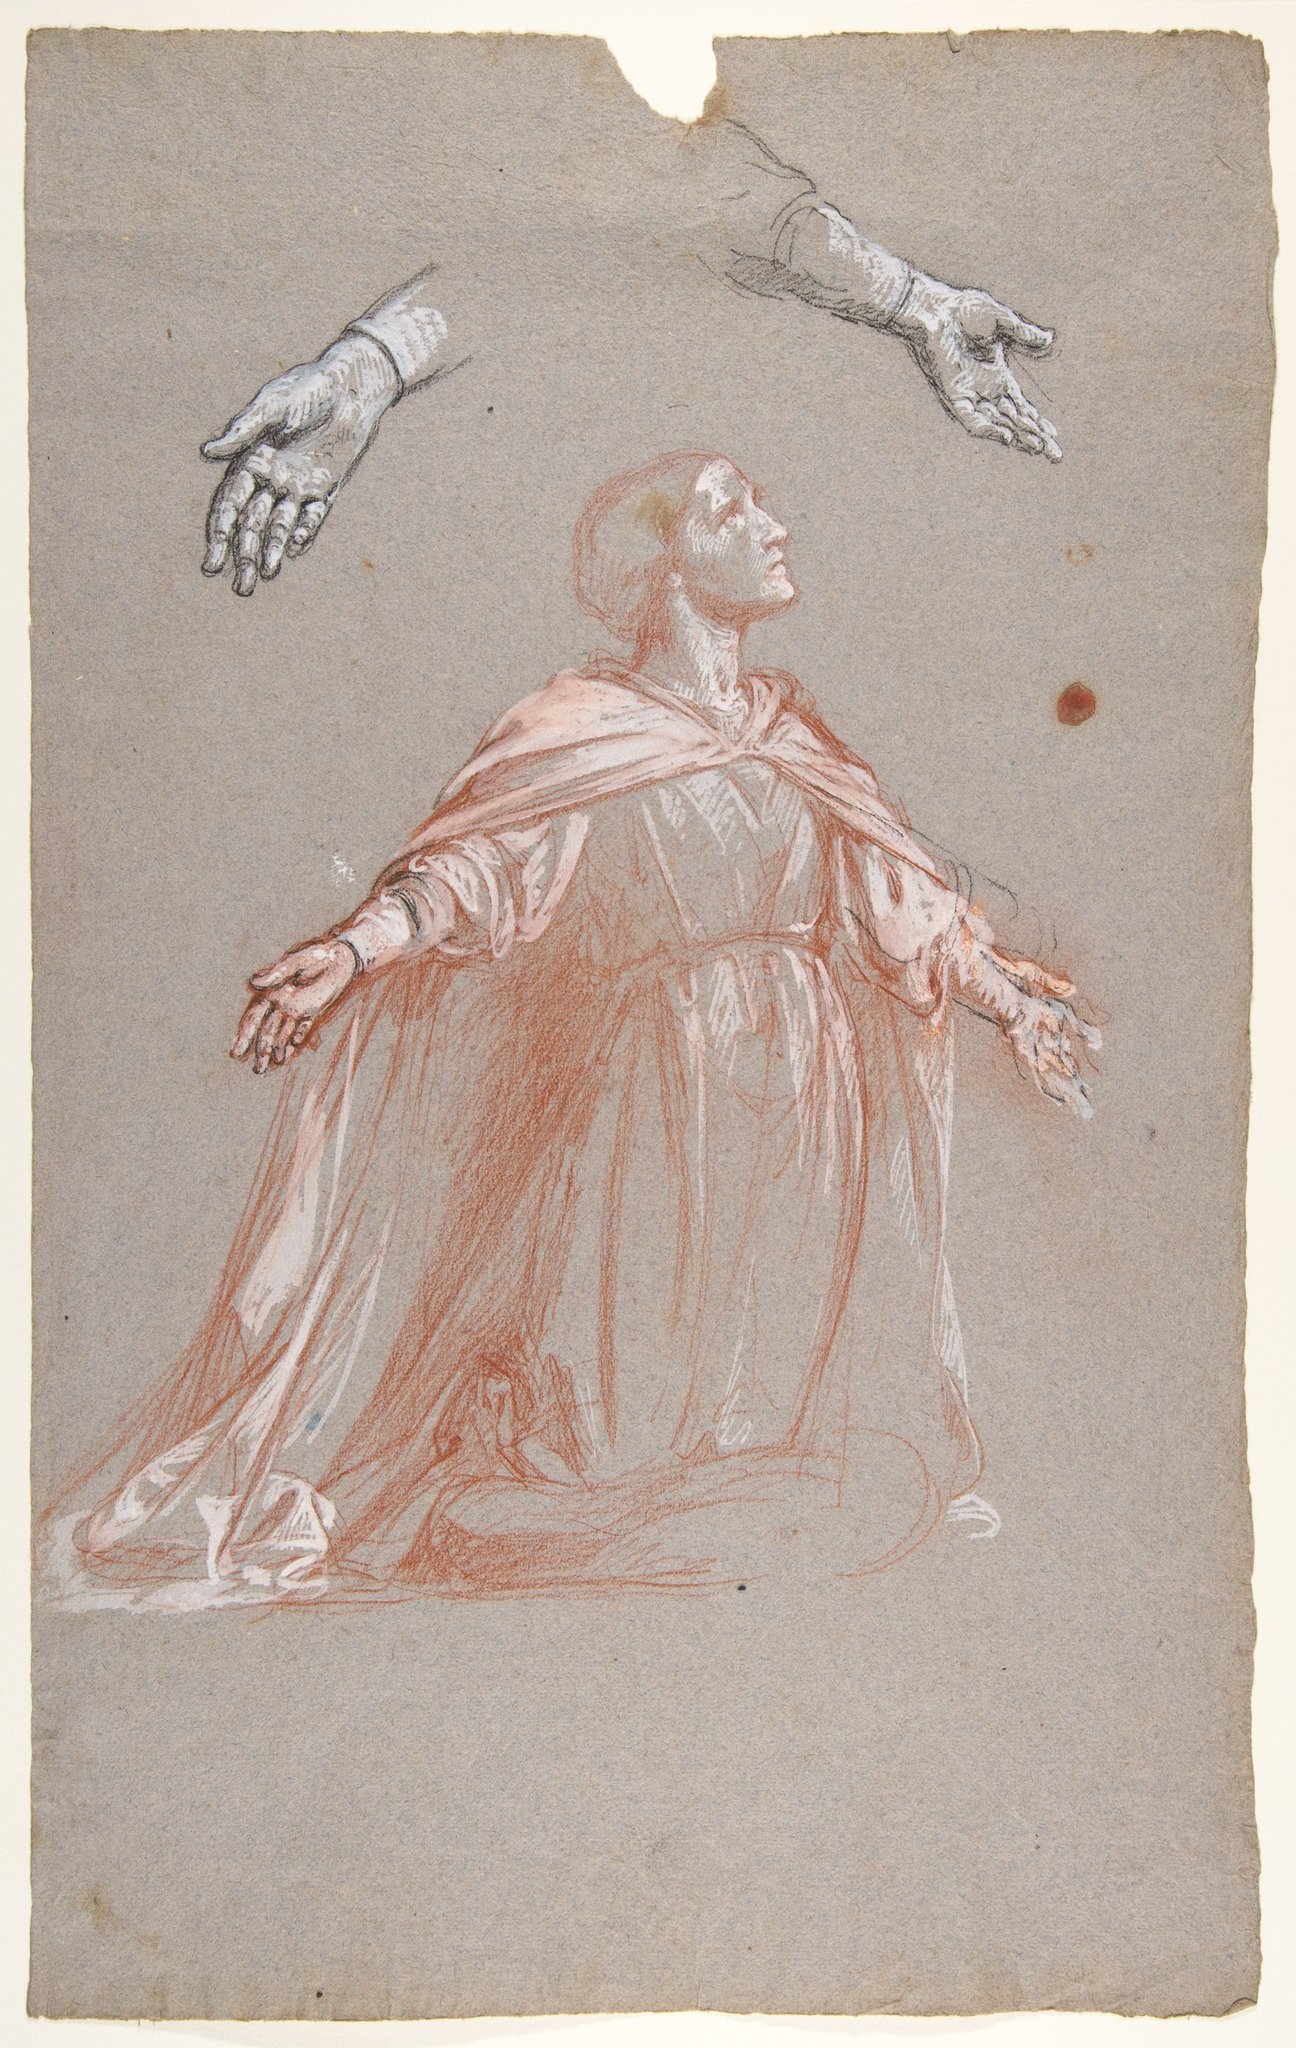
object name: drawing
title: Sainte Clotilde (middle register; study for wall paintings in the Chapel of Saint Remi, Sainte-Clotilde, Paris, 1858)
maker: isidore pils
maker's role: artist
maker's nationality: french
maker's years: 1813-1875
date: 1801-1900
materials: chalk, gouache, paper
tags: hands,saints